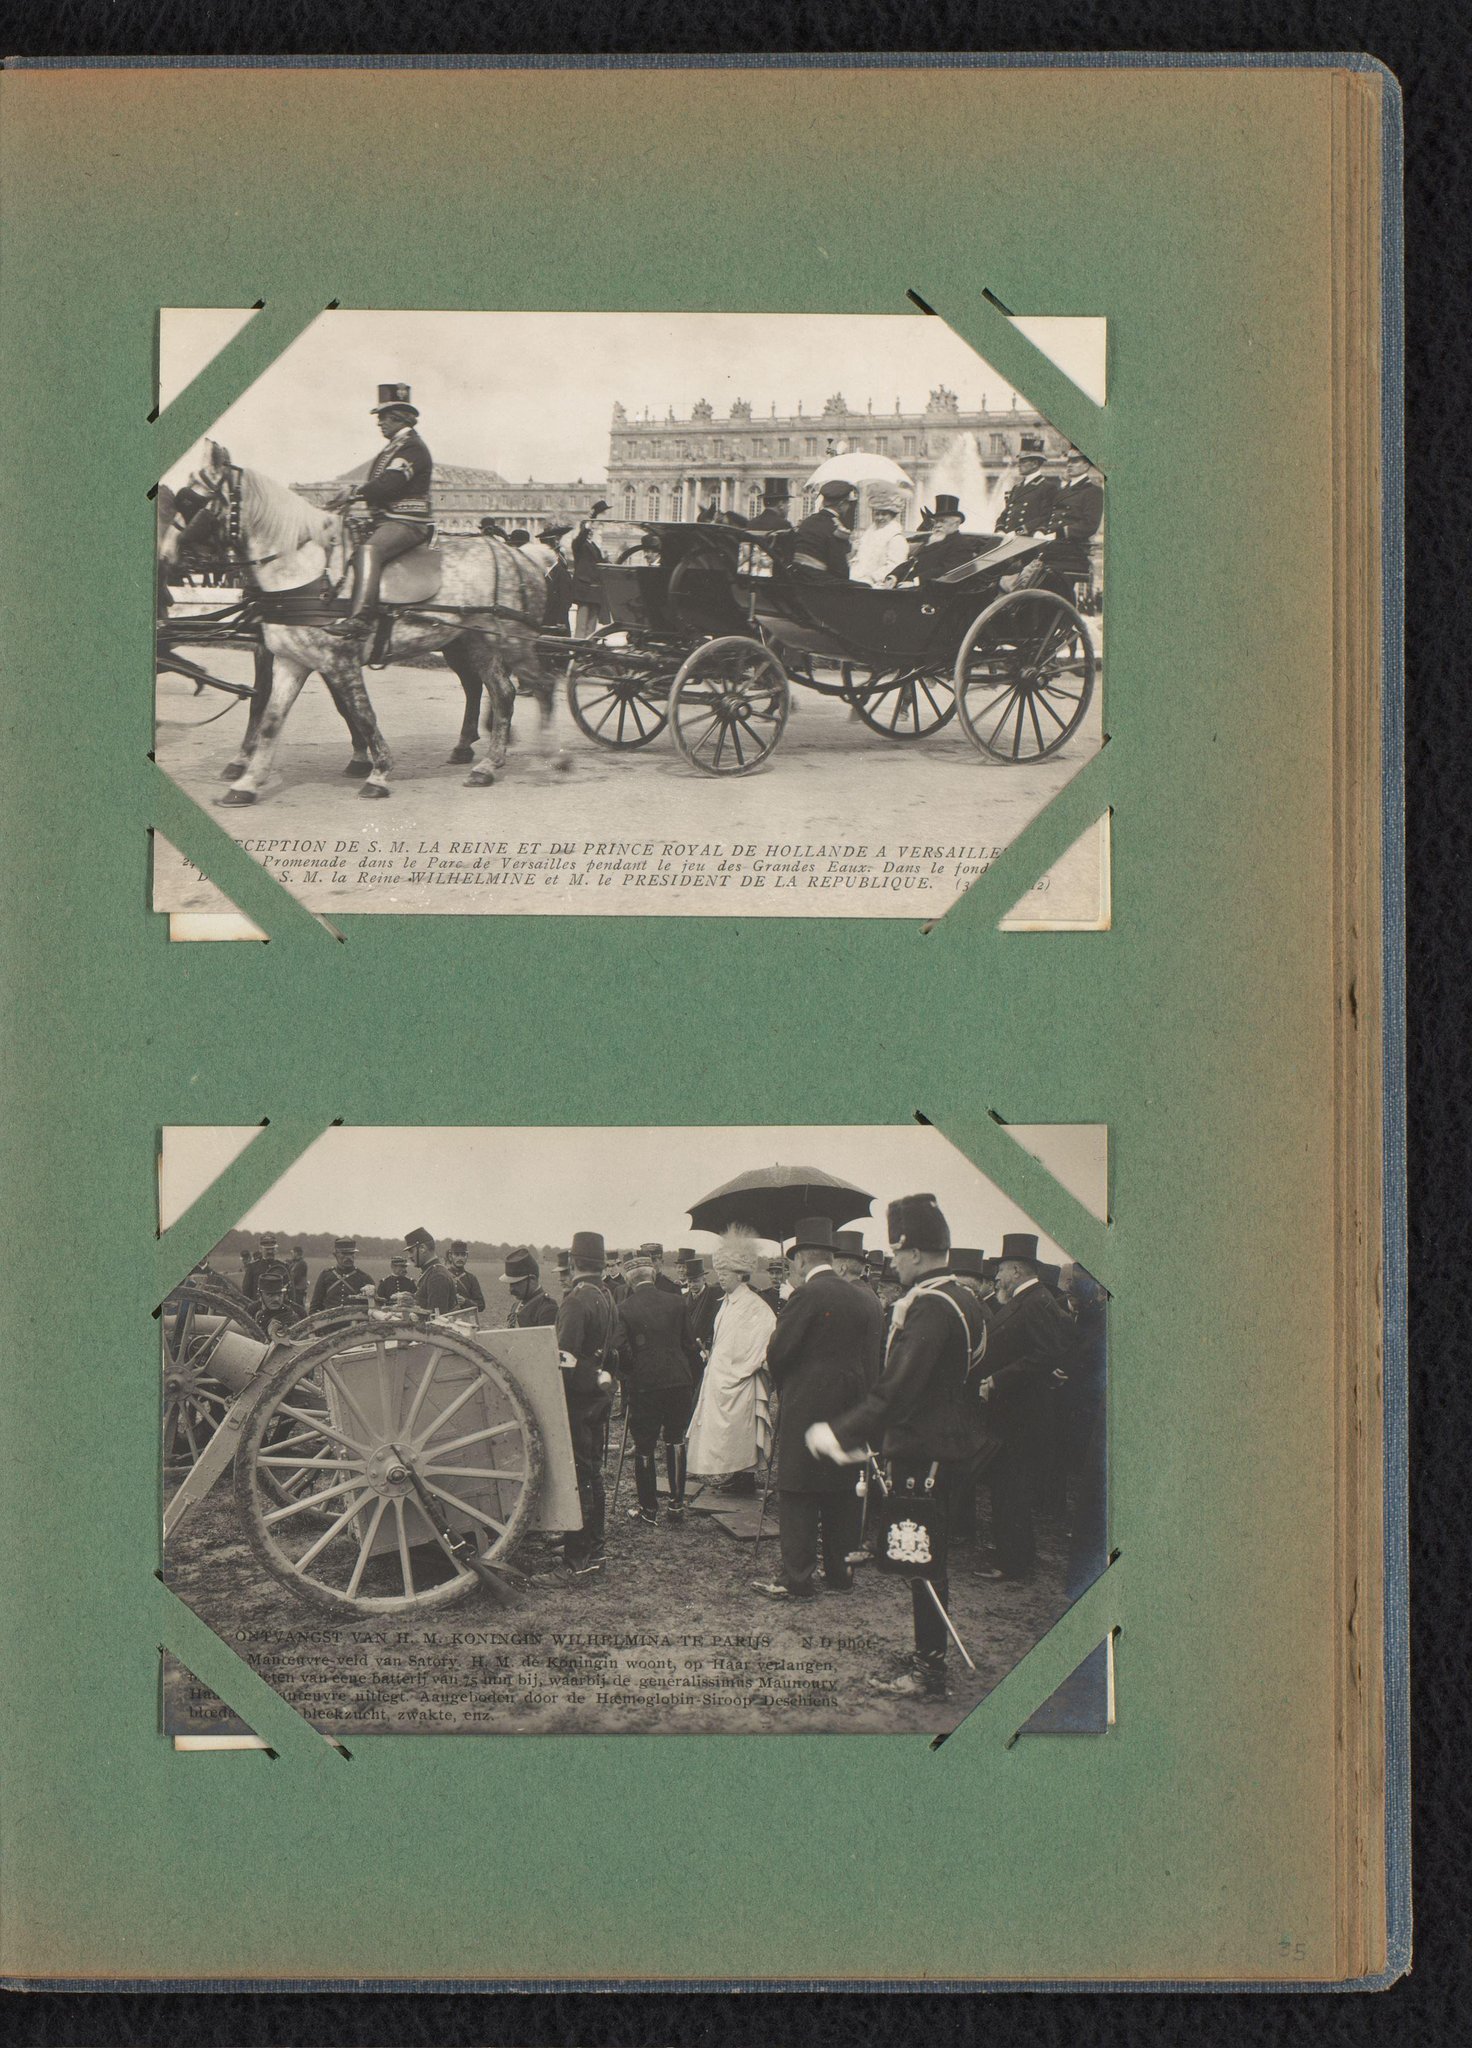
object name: album leaf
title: Twee prentbriefkaarten van het bezoek van koningin Wilhelmina en prins Hendrik aan Versailles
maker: Anonymous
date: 1912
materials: paper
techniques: gelatin silver print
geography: versailles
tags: the hague, print maker, wilhelmina of the netherlands, president ~ head of republic, military demonstrations, queen, firearms: cannon, four-wheeled vehicle drawn by two animals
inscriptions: inscription: ‘Reception de S.M. la Reine et du prince royal de Hollande à Versailles (...) Juin 1912).’, inscription: ‘Ontvangst van H.M. Koningin Wilhelmina te Parijs (...) zwakte, enz.’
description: Deze foto's maken deel uit van een album.